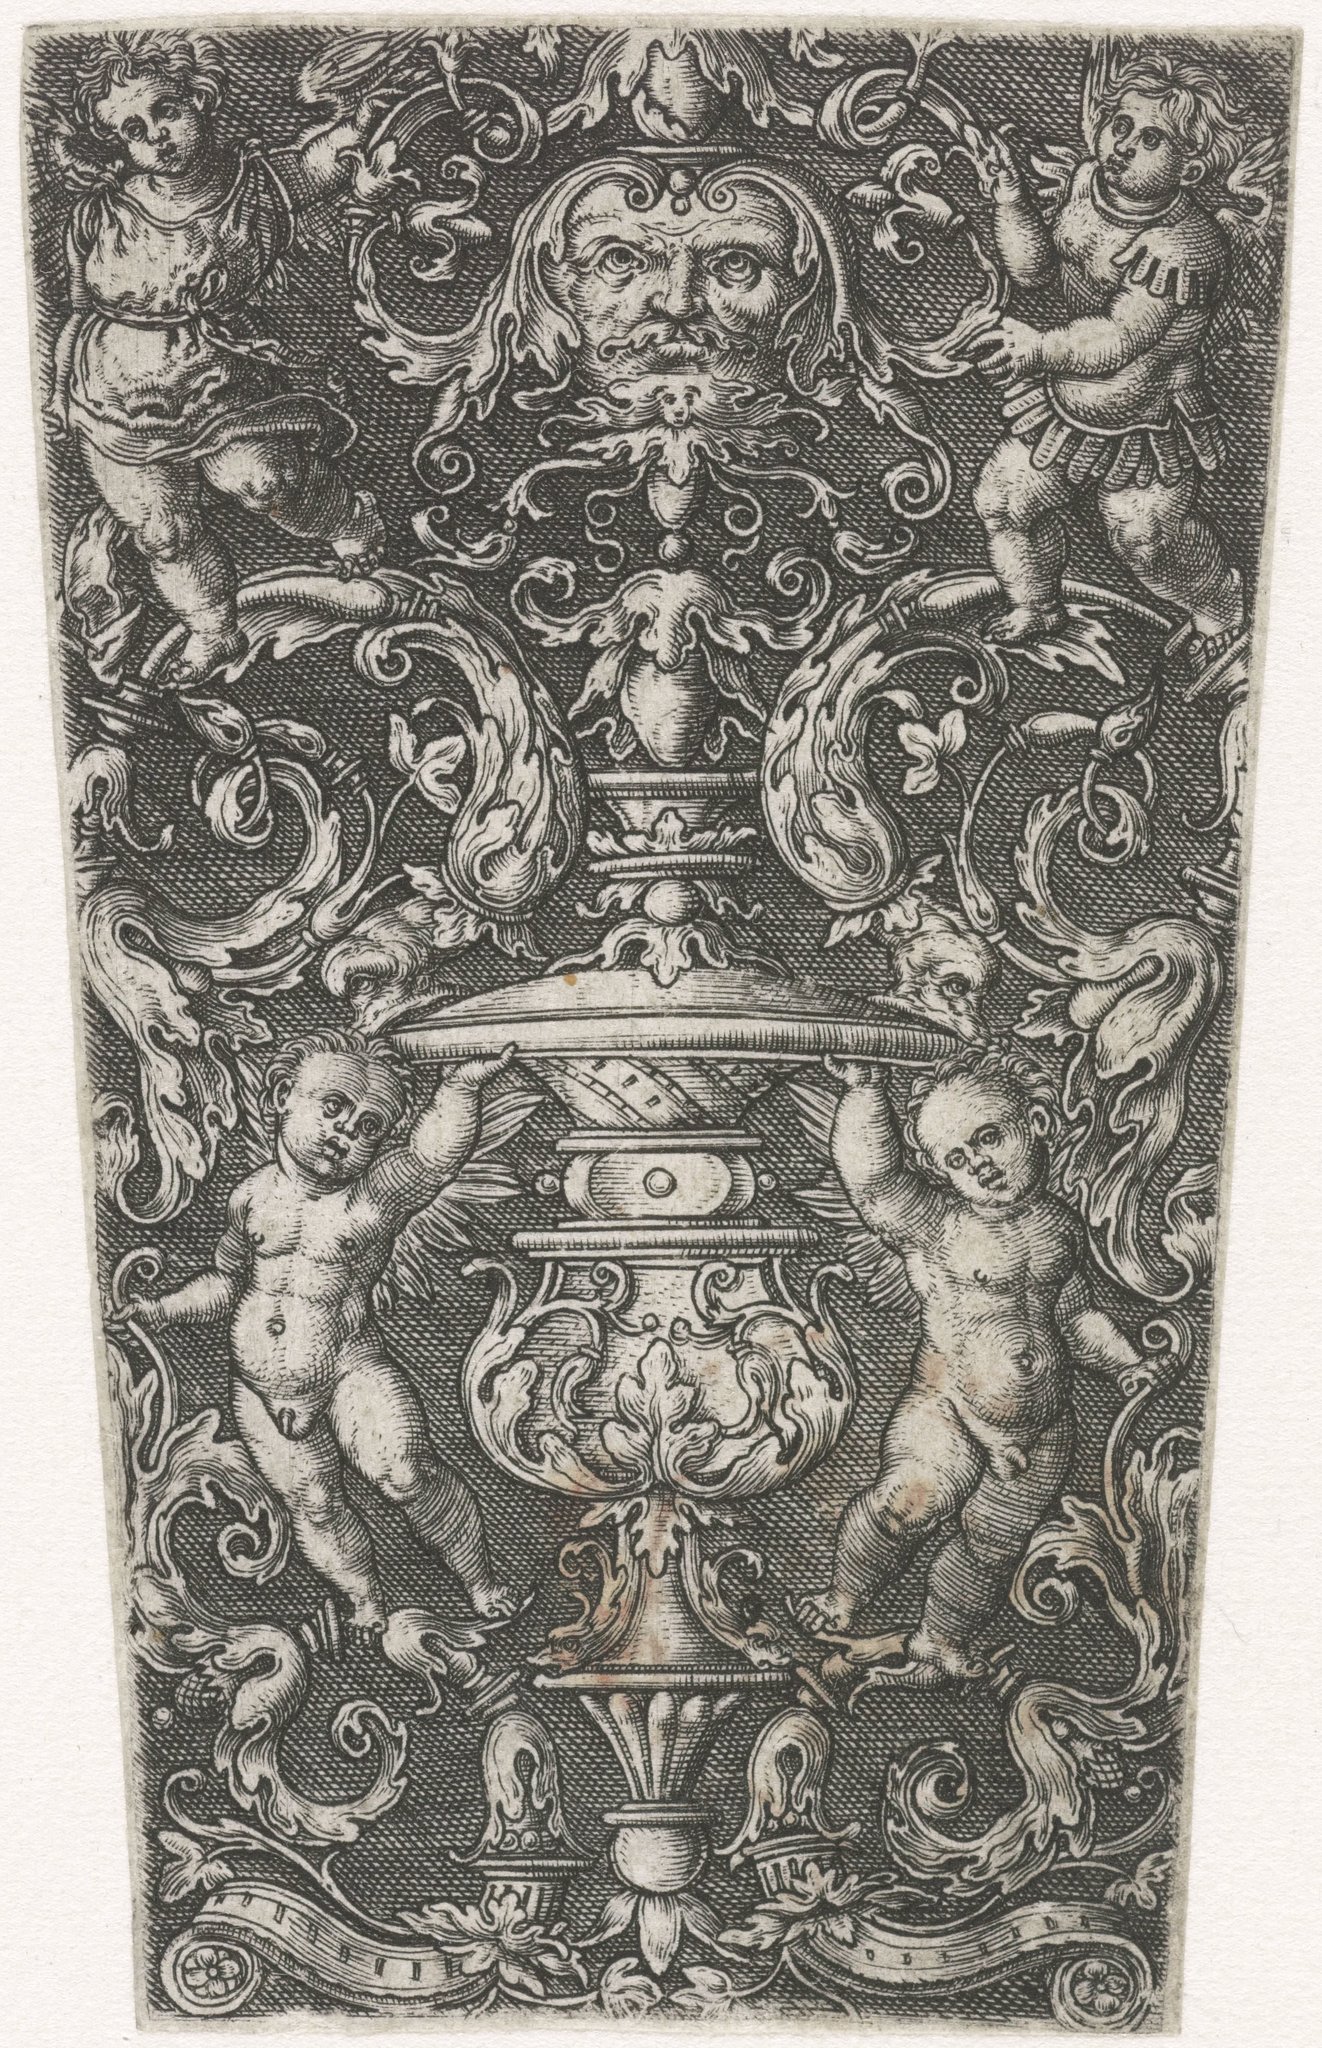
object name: print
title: Vlakdecoratie, kandelaber met een vaas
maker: Anonymous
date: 1500-1600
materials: paper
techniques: engraving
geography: netherlands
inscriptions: collector's mark: Lugt 240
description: Kandelaber met een vaas, bladranken en een mascaron tussen vier putti.